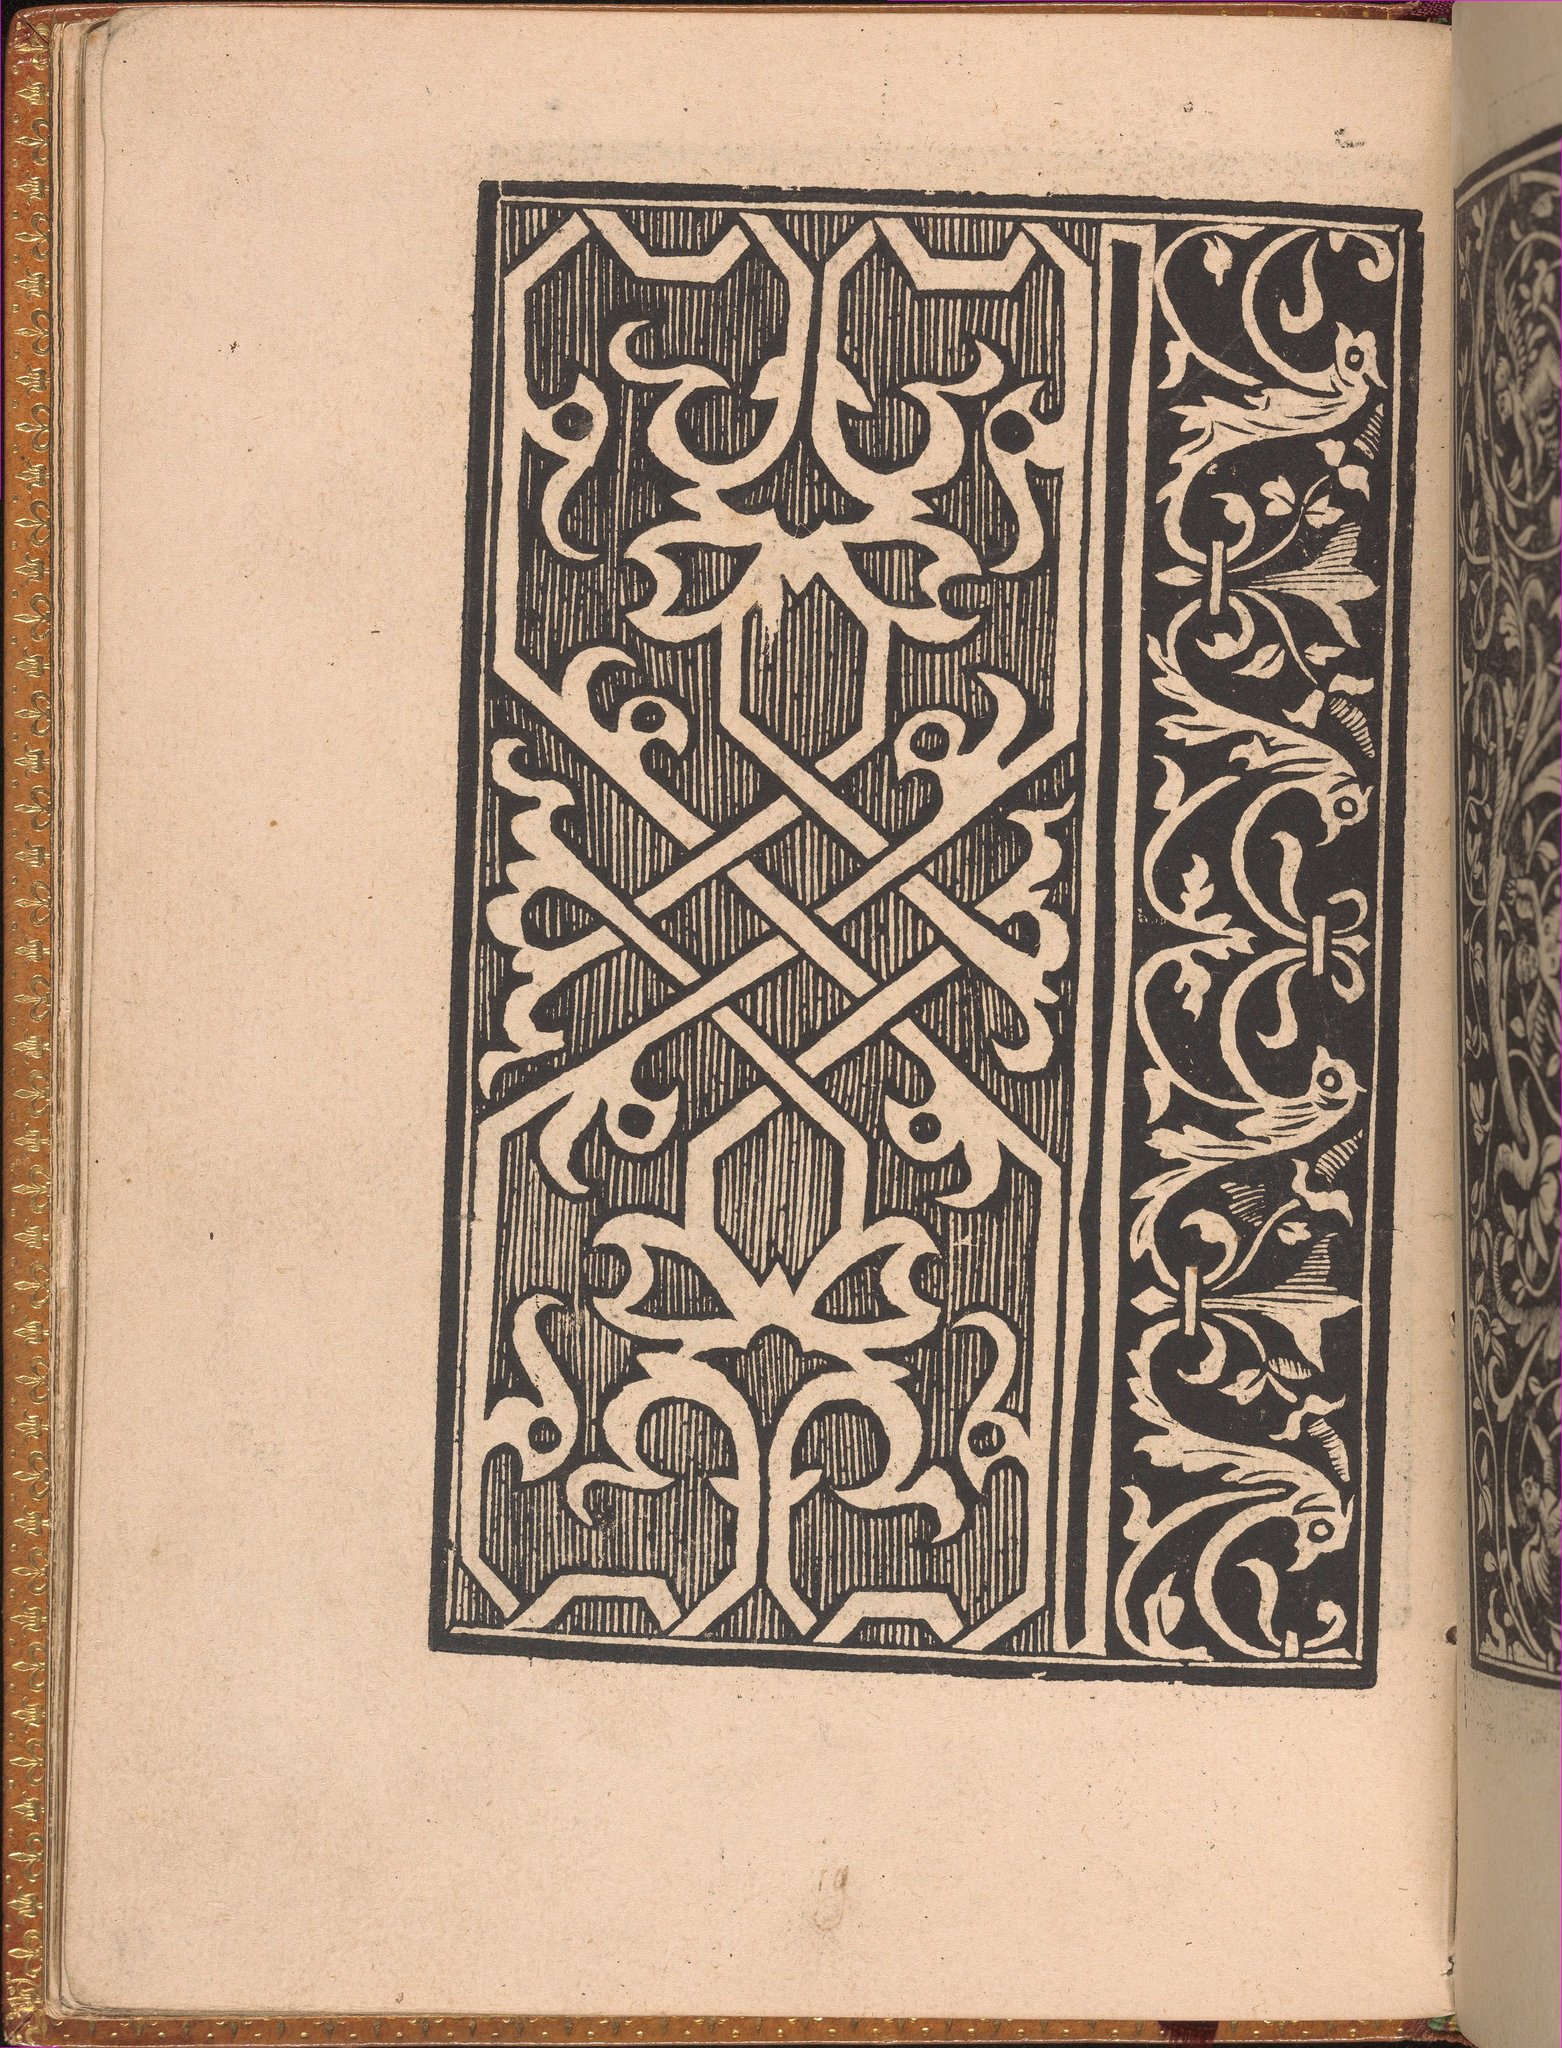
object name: book print ornament architecture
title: Convivio delle Belle Donne, page 18 (verso)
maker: nicolò zoppino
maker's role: publisher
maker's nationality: italian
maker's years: 1478-1544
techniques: woodcut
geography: italy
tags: eyes,leaves